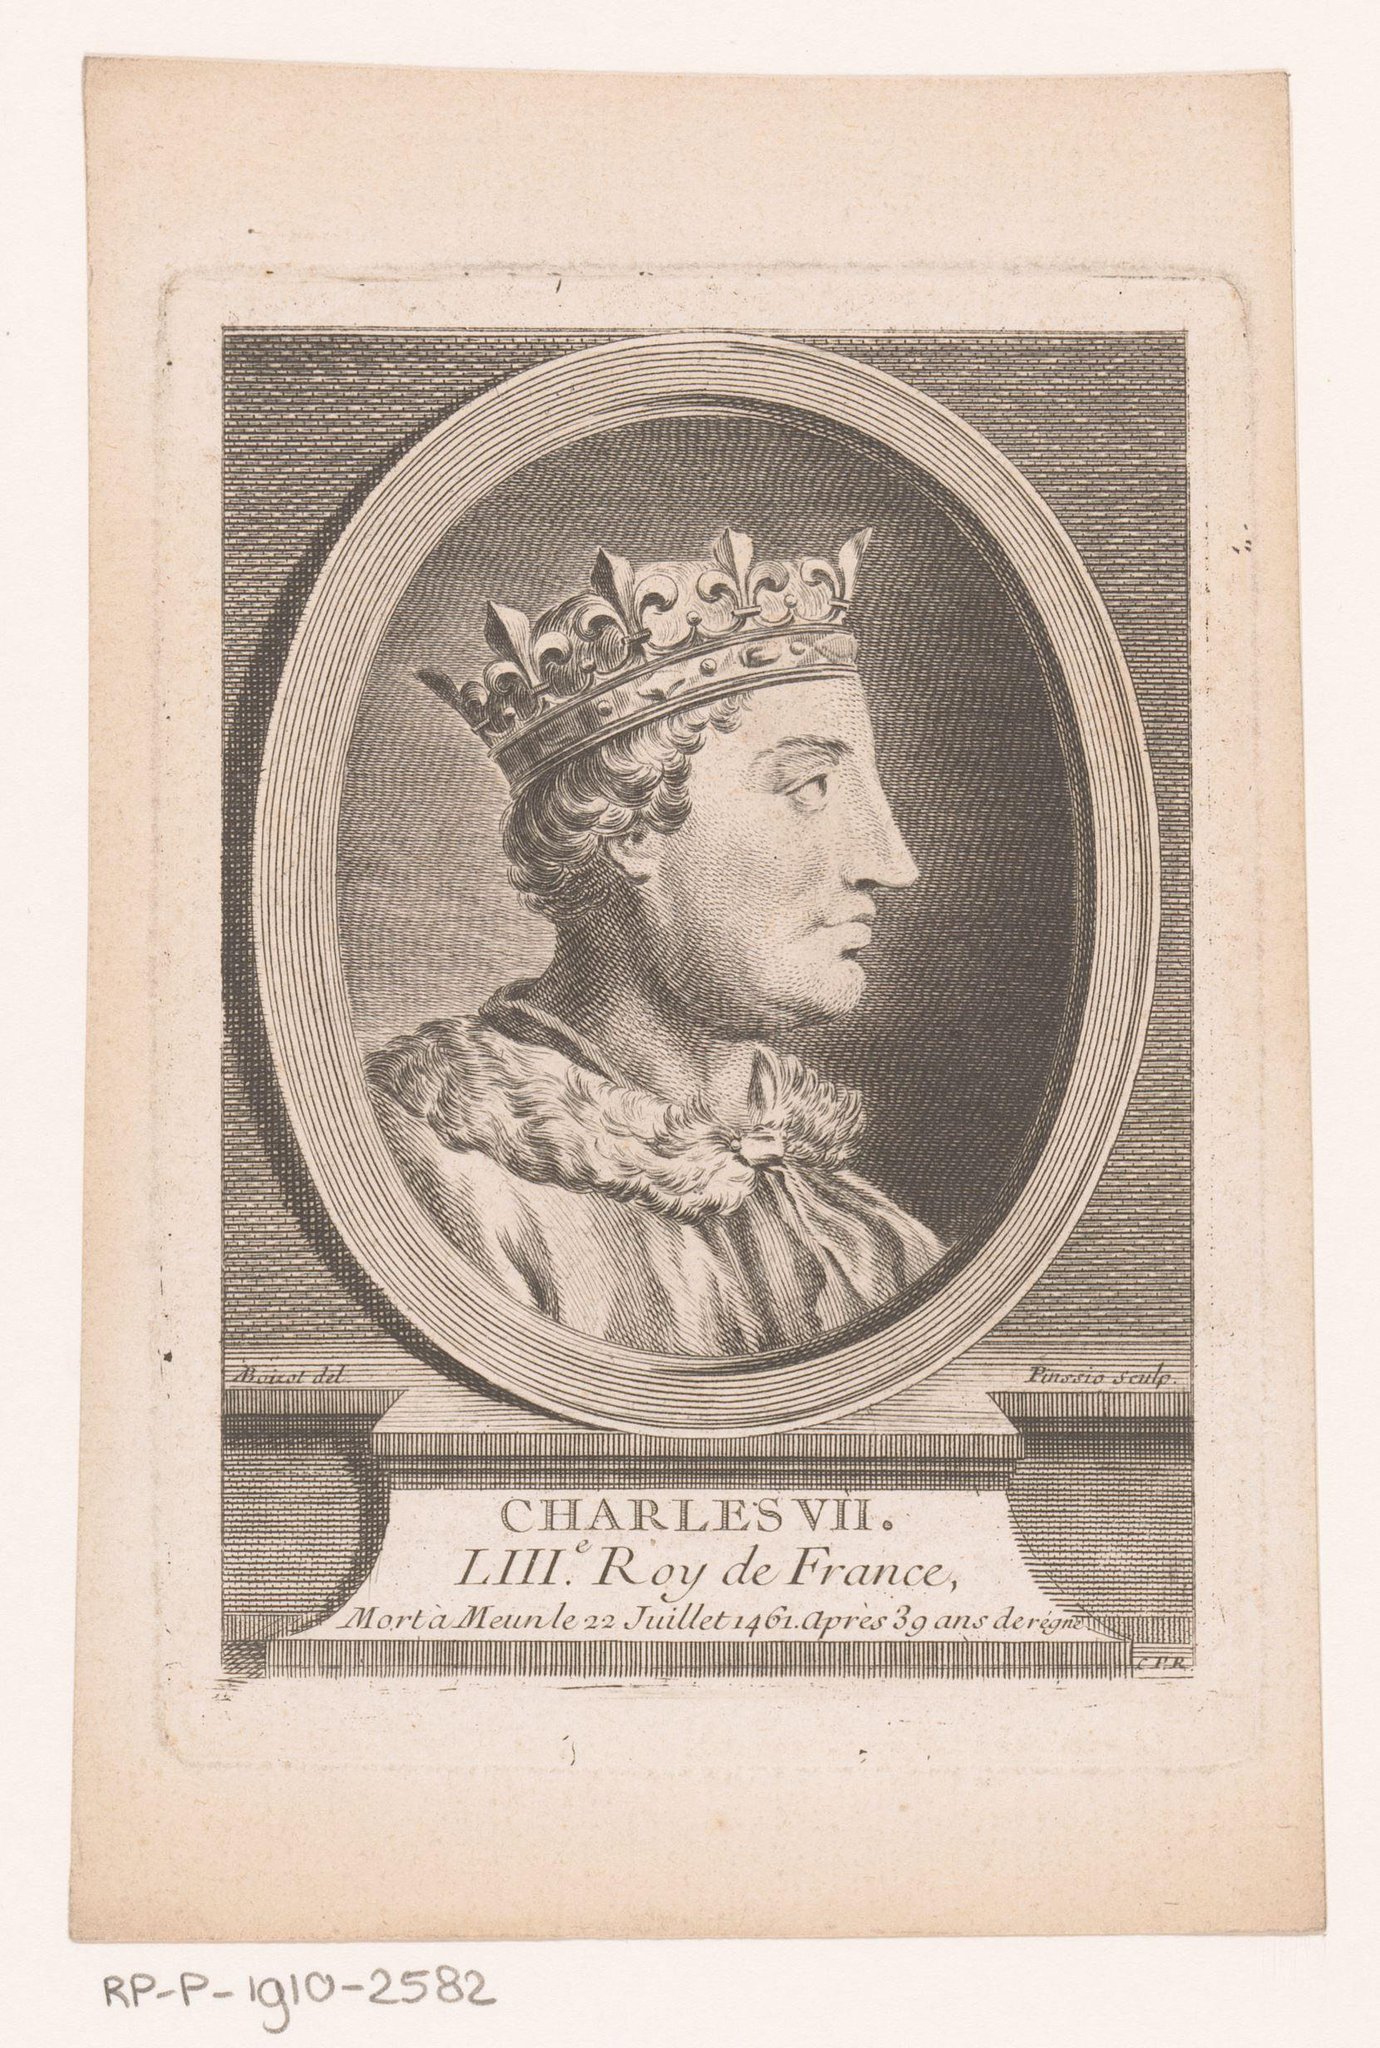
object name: book illustration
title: Portret van Karel VII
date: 1755-1765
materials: paper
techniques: engraving, etching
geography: paris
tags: paris, historical persons, king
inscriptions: collector's mark: Lugt 2228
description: Prent uit: Dreux du Radier, Jean-François. L'Europe illustré, contenant l'histoire abregée des souverains, des princes, des prélats, des ministres, (...) en Europe: dans le XVe. siècle compris, jusqu'à présent. Parijs: Michel Odieuvre en André-François Le Breton, 1755-1765.